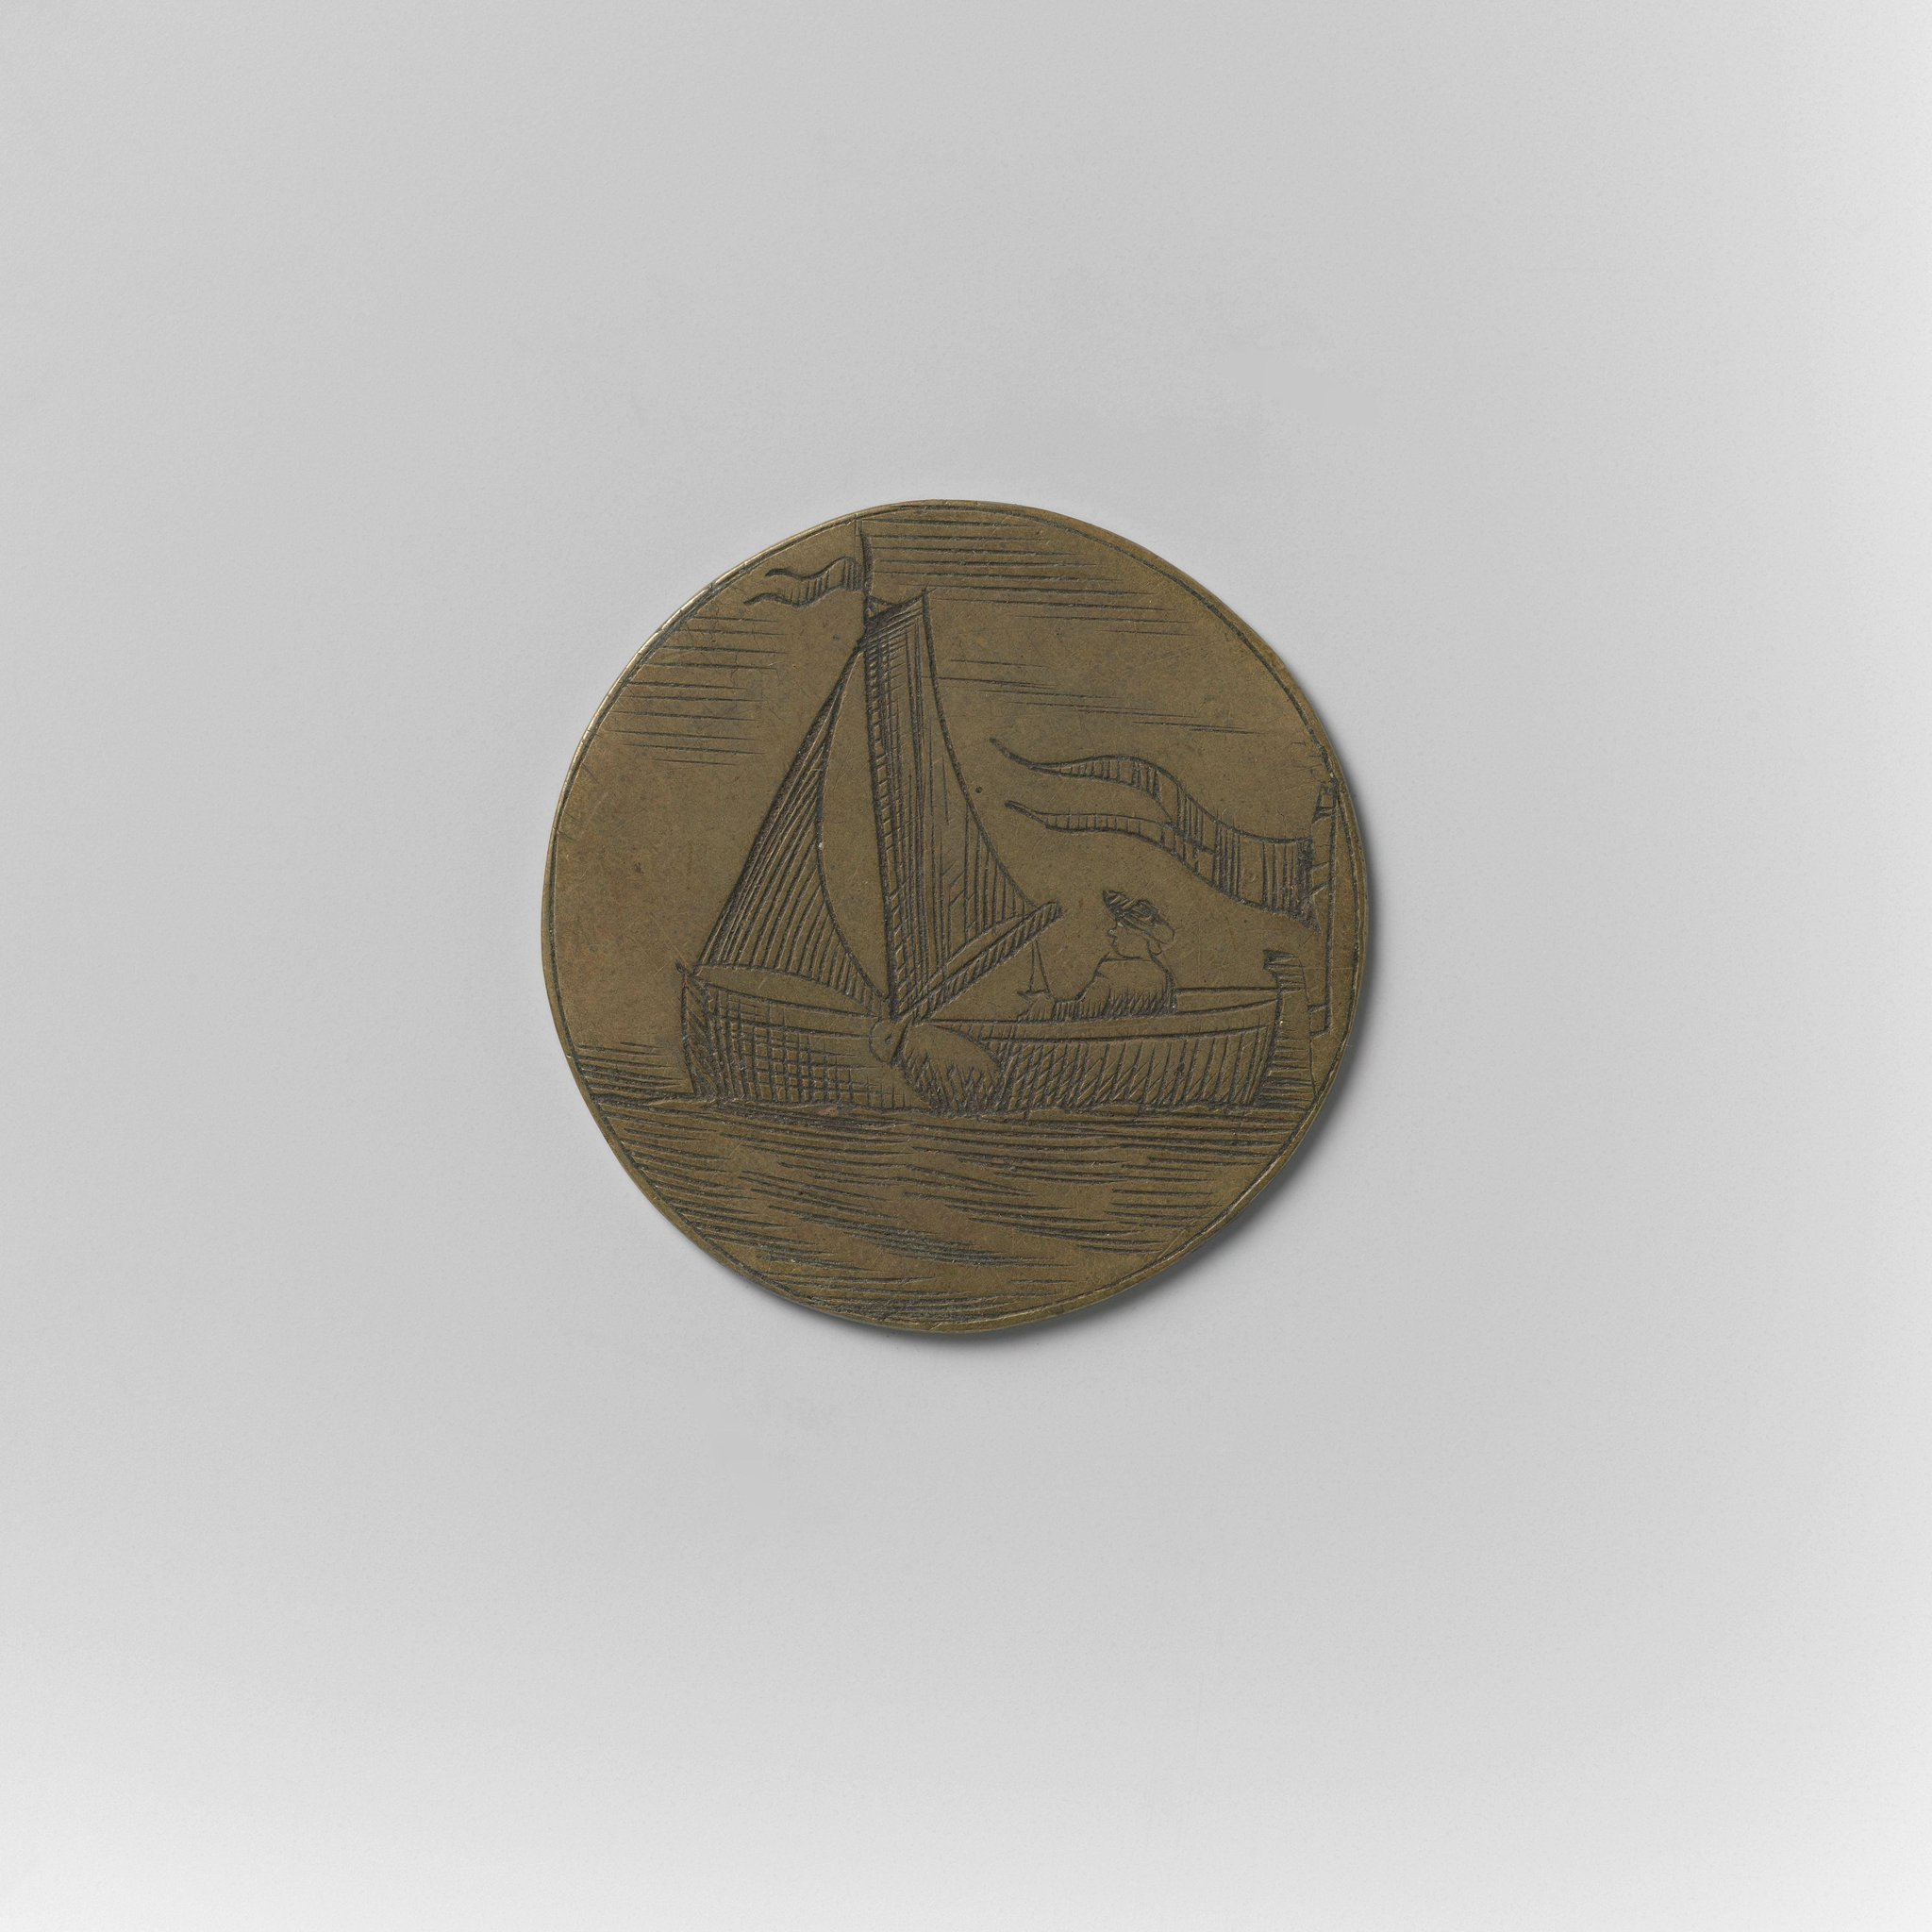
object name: medal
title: Presentiepenning van het Roei-, Steiger- en Schuitenvoerdersgilde te Amsterdam (Nieuwe Brug), 1659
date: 1659-1797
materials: brass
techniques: engraving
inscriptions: inscription: ‘A° / Den 25ste Maart / CORNELIS / TEISSEIRE / (CT-merk tussen N - B)’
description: Ronde plaat messing gegraveerd op de voorzijde een man in een zeilscheepje naar links, op de keerzijde vijf regels tekst, op naam van Cornelis Teisseire 25 maart 1797 NB